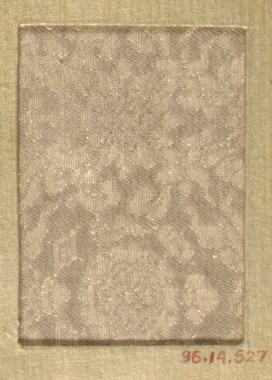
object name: piece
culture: japanese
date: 1701-1900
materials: silk